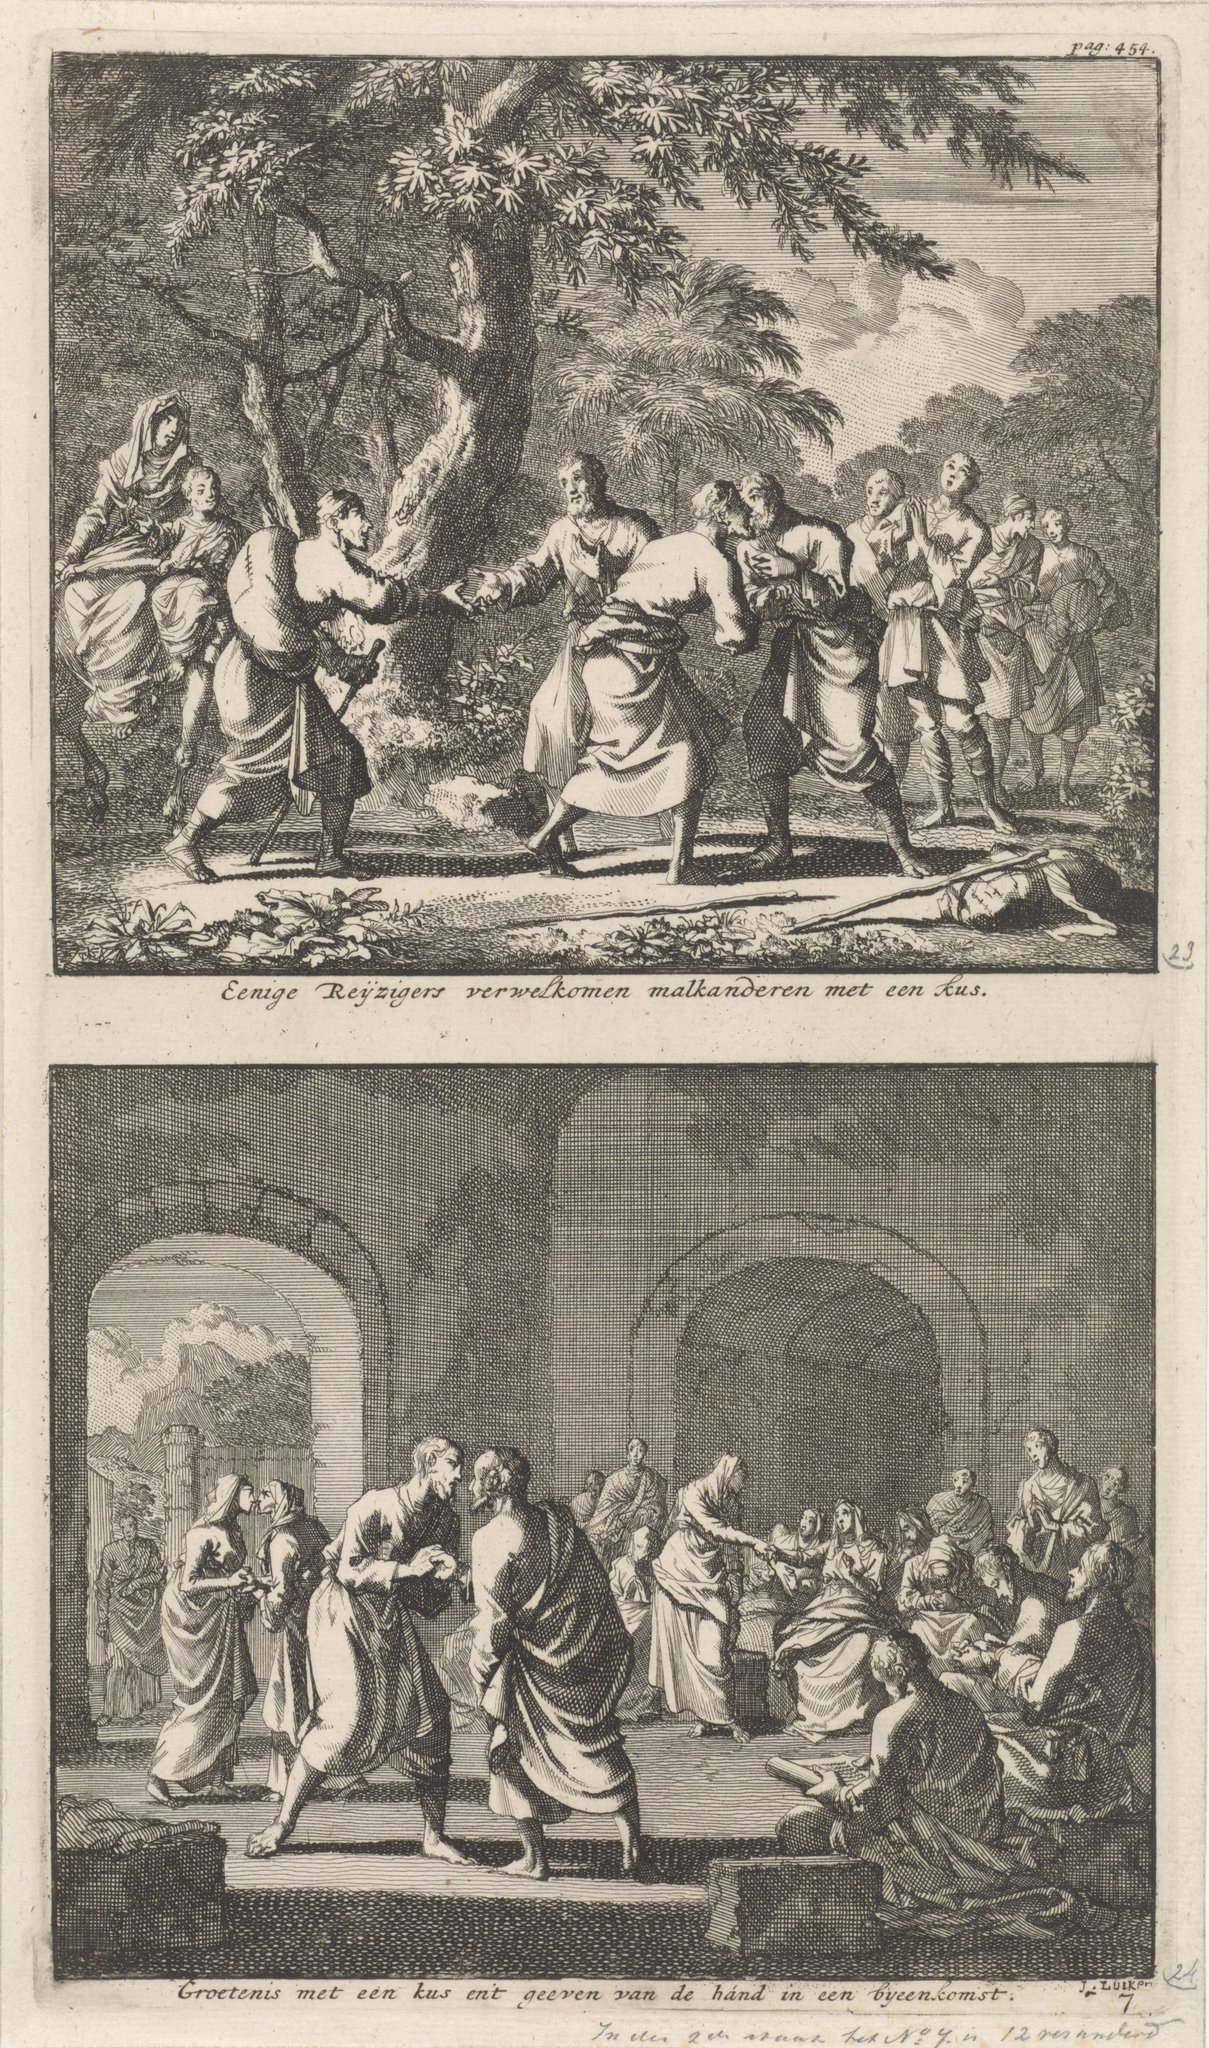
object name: book illustration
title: Eenige Reijzigers verwelkomen malkanderen met een kus / Groetenis met een kus en't geven van de hand in een byeenkomst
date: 1700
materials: paper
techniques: etching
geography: amsterdam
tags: the early christian churches, e.g. armenians, copts, syrians, shaking hands, 'dextrarum junctio', embracing each other, kissing, 'en route', traveller under way, meeting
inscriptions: collector's mark: Lugt 2228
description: Twee voorstellingen op een plaat. Boven: twee reizende gezelschappen van eerste christenen begroeten elkaar in een bos. Ze schudden de hand en kussen elkaar op de wang. Onder: tijdens een bijeenkomst van eerste christenen begroeten mensen elkaar door de hand te schudden of een kus te geven op de wang.